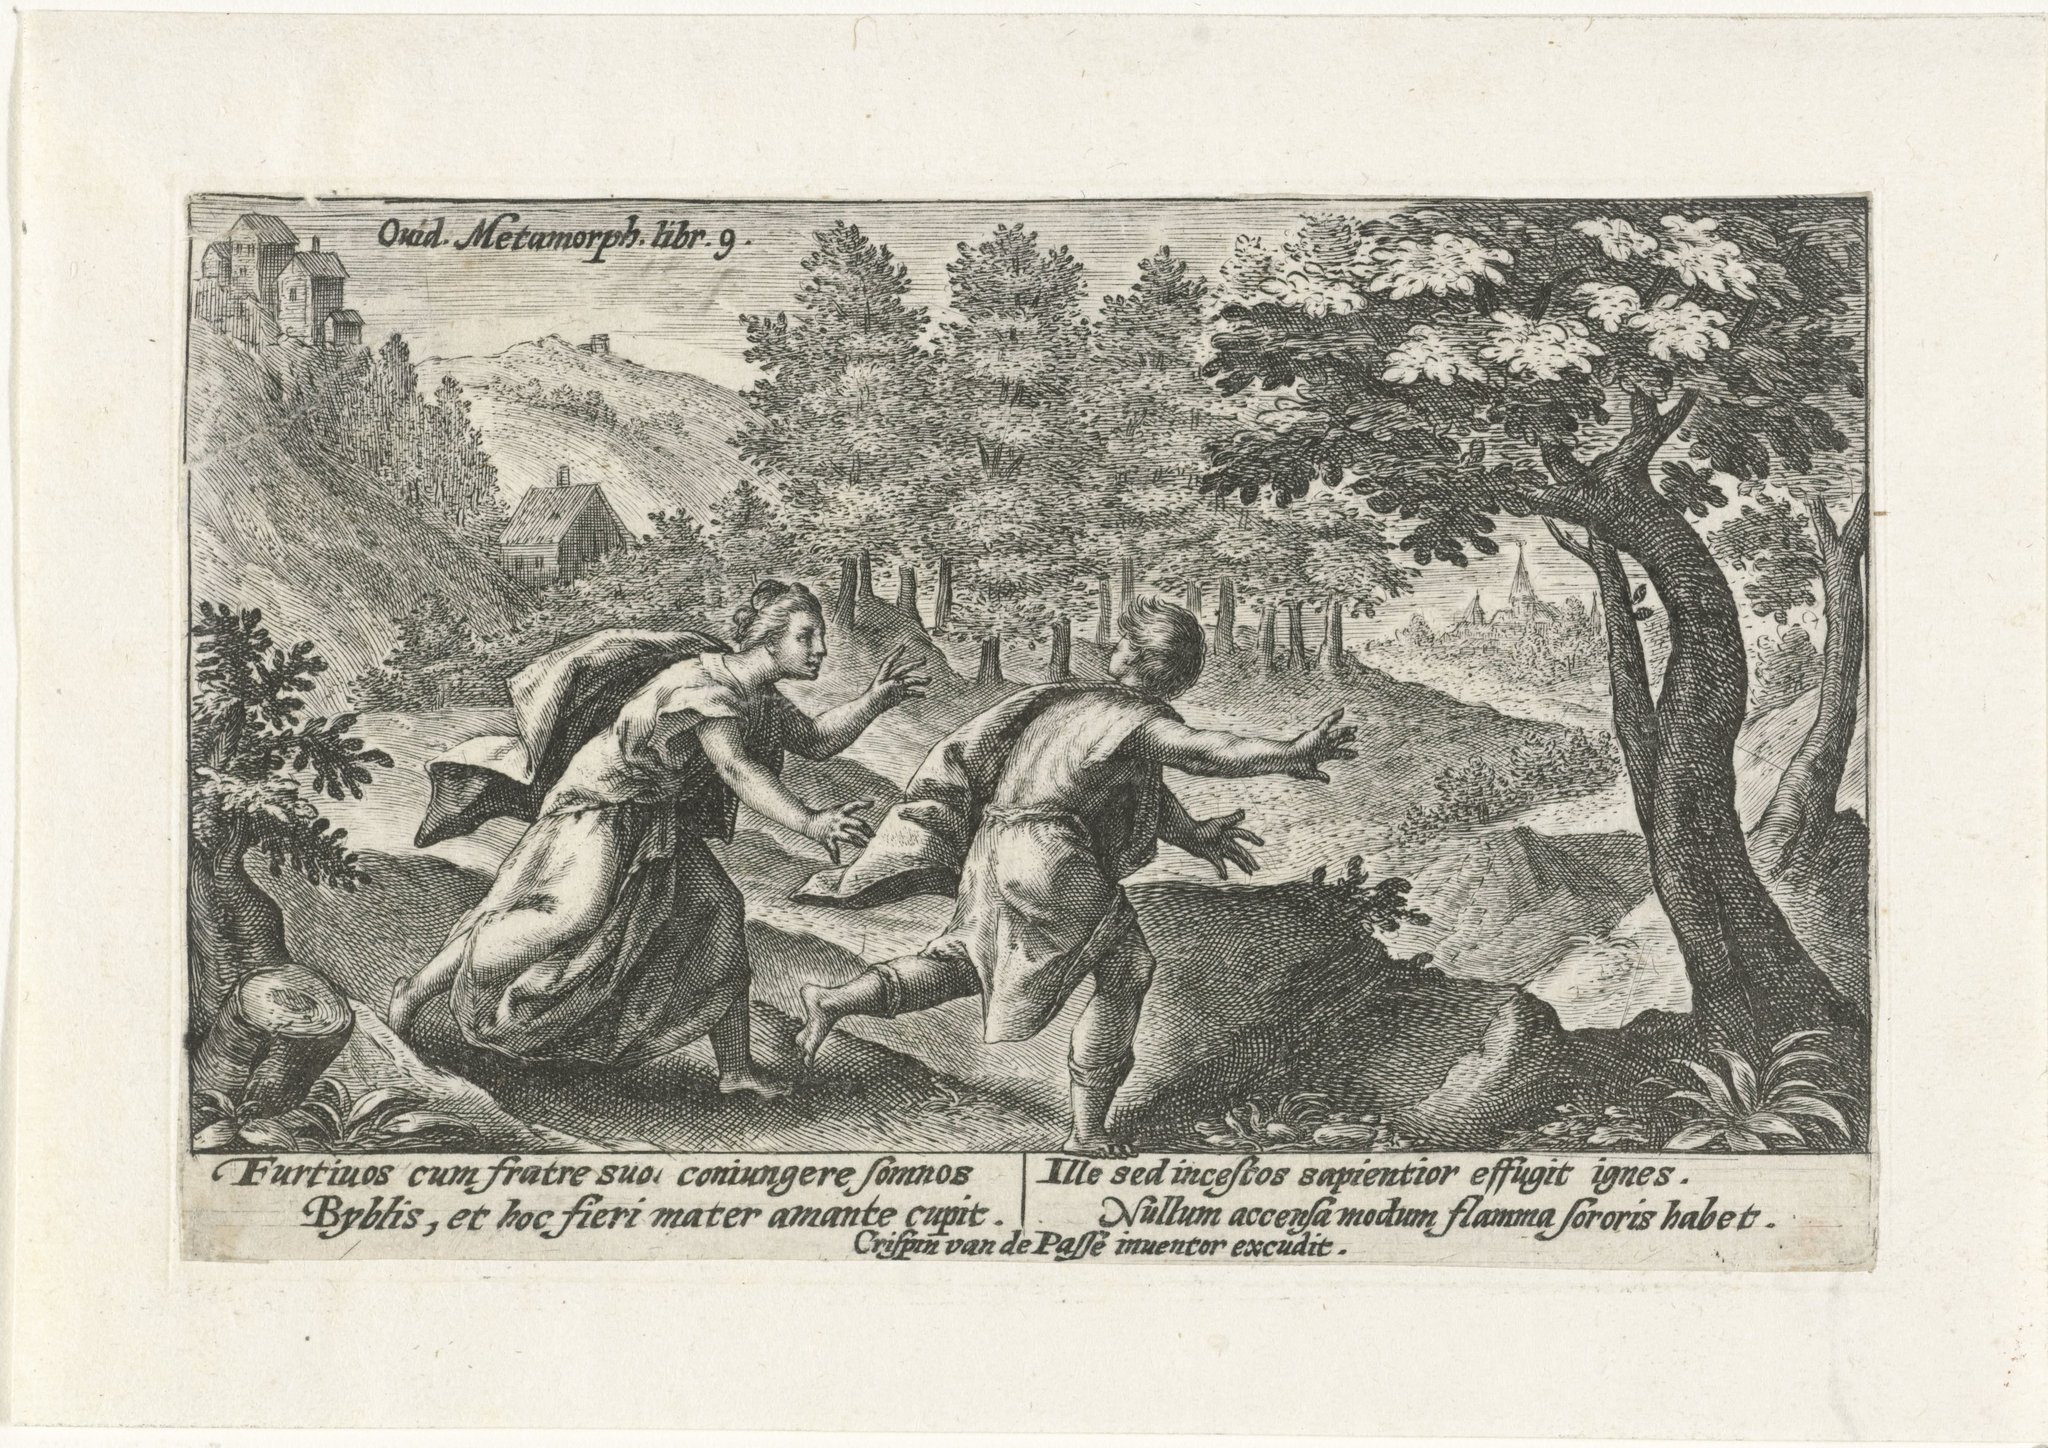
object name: print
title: Byblis en Caunus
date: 1602-1607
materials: paper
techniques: engraving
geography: cologne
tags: byblis falls in love with her brother caunus, who scorns her love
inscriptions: collector's mark: Lugt 240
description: Byblis is verliefd op haar broer Caunus, die voor haar wegvlucht. In de marge een vierregelig onderschrift, in twee kolommen, in het Latijn.